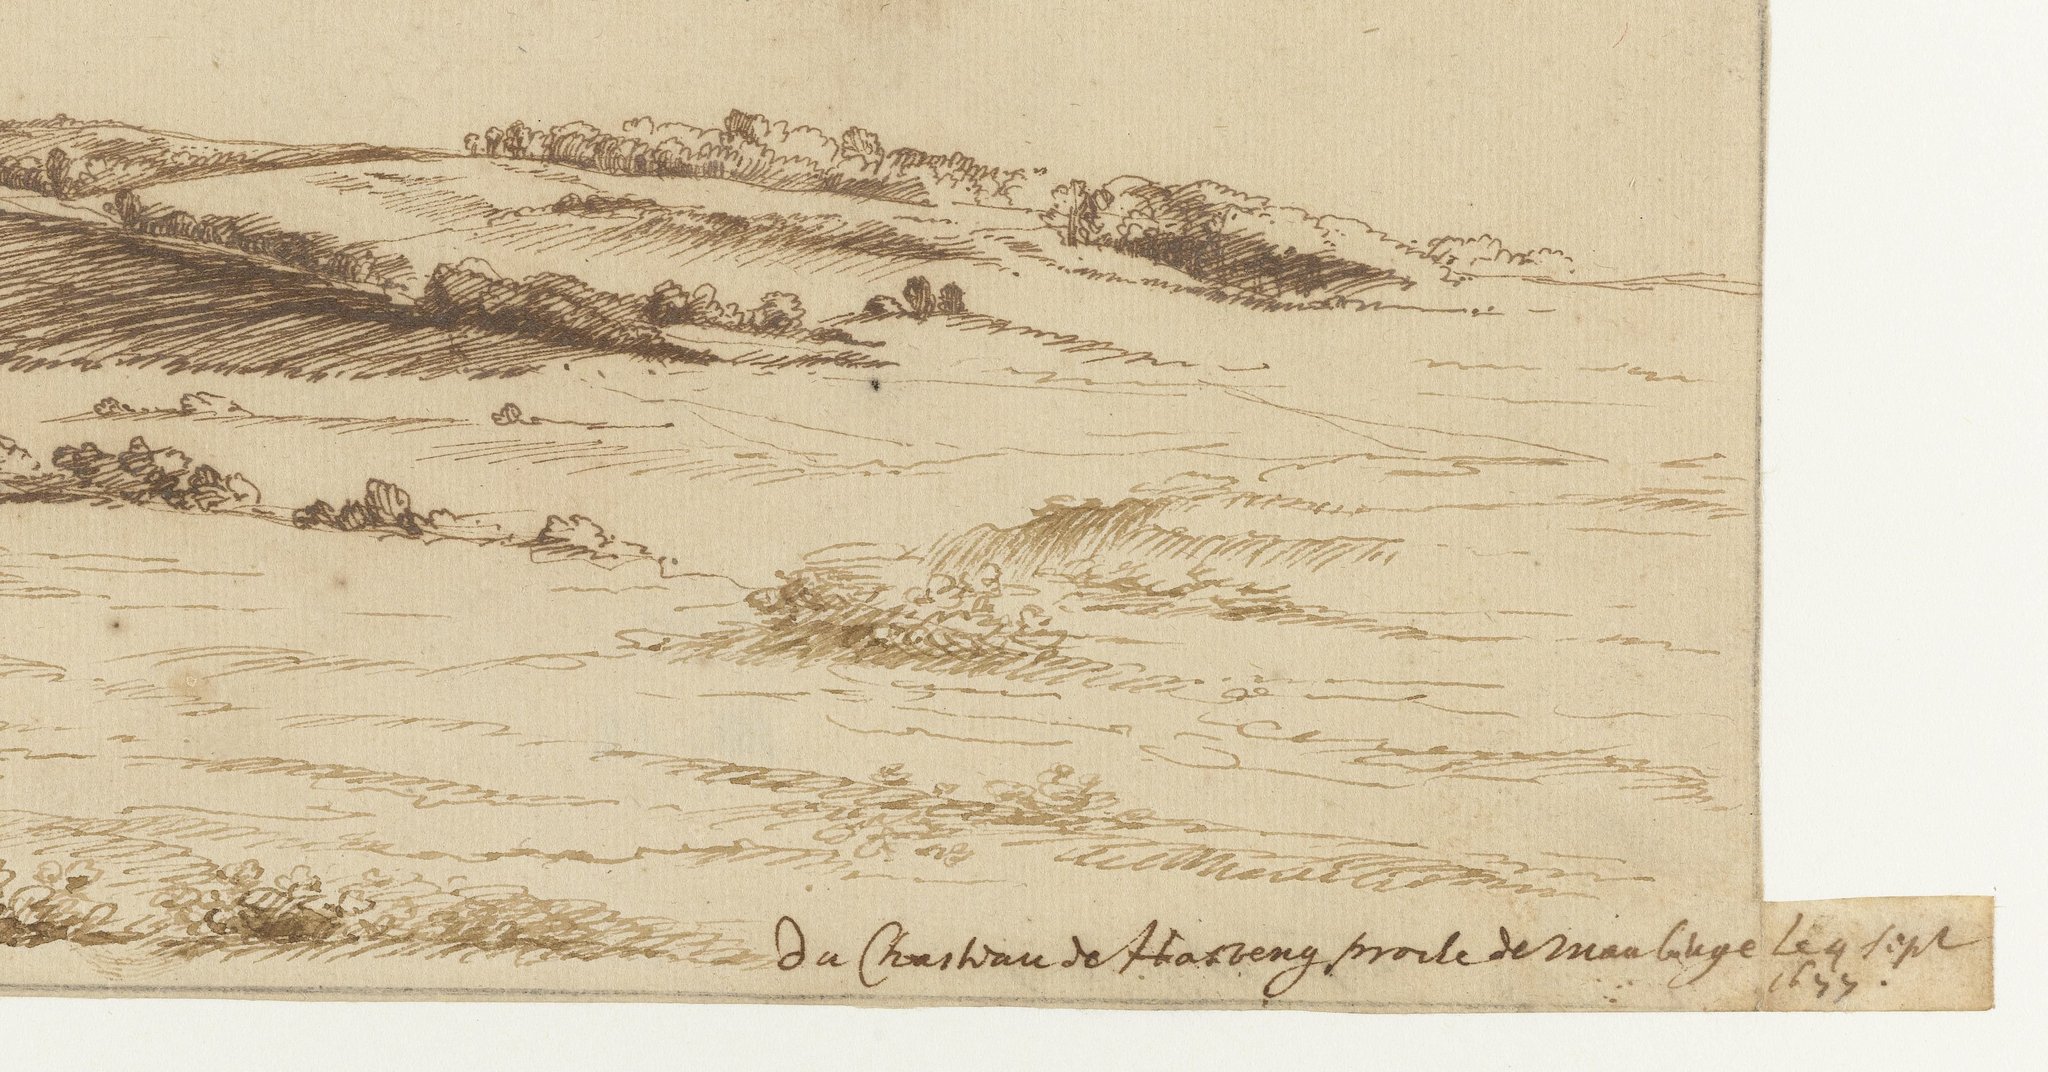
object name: drawing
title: Assevent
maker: constantijn huygens (ii)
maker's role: draughtsman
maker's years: 1628-1697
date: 1677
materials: ink, paper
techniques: pen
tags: low hill country